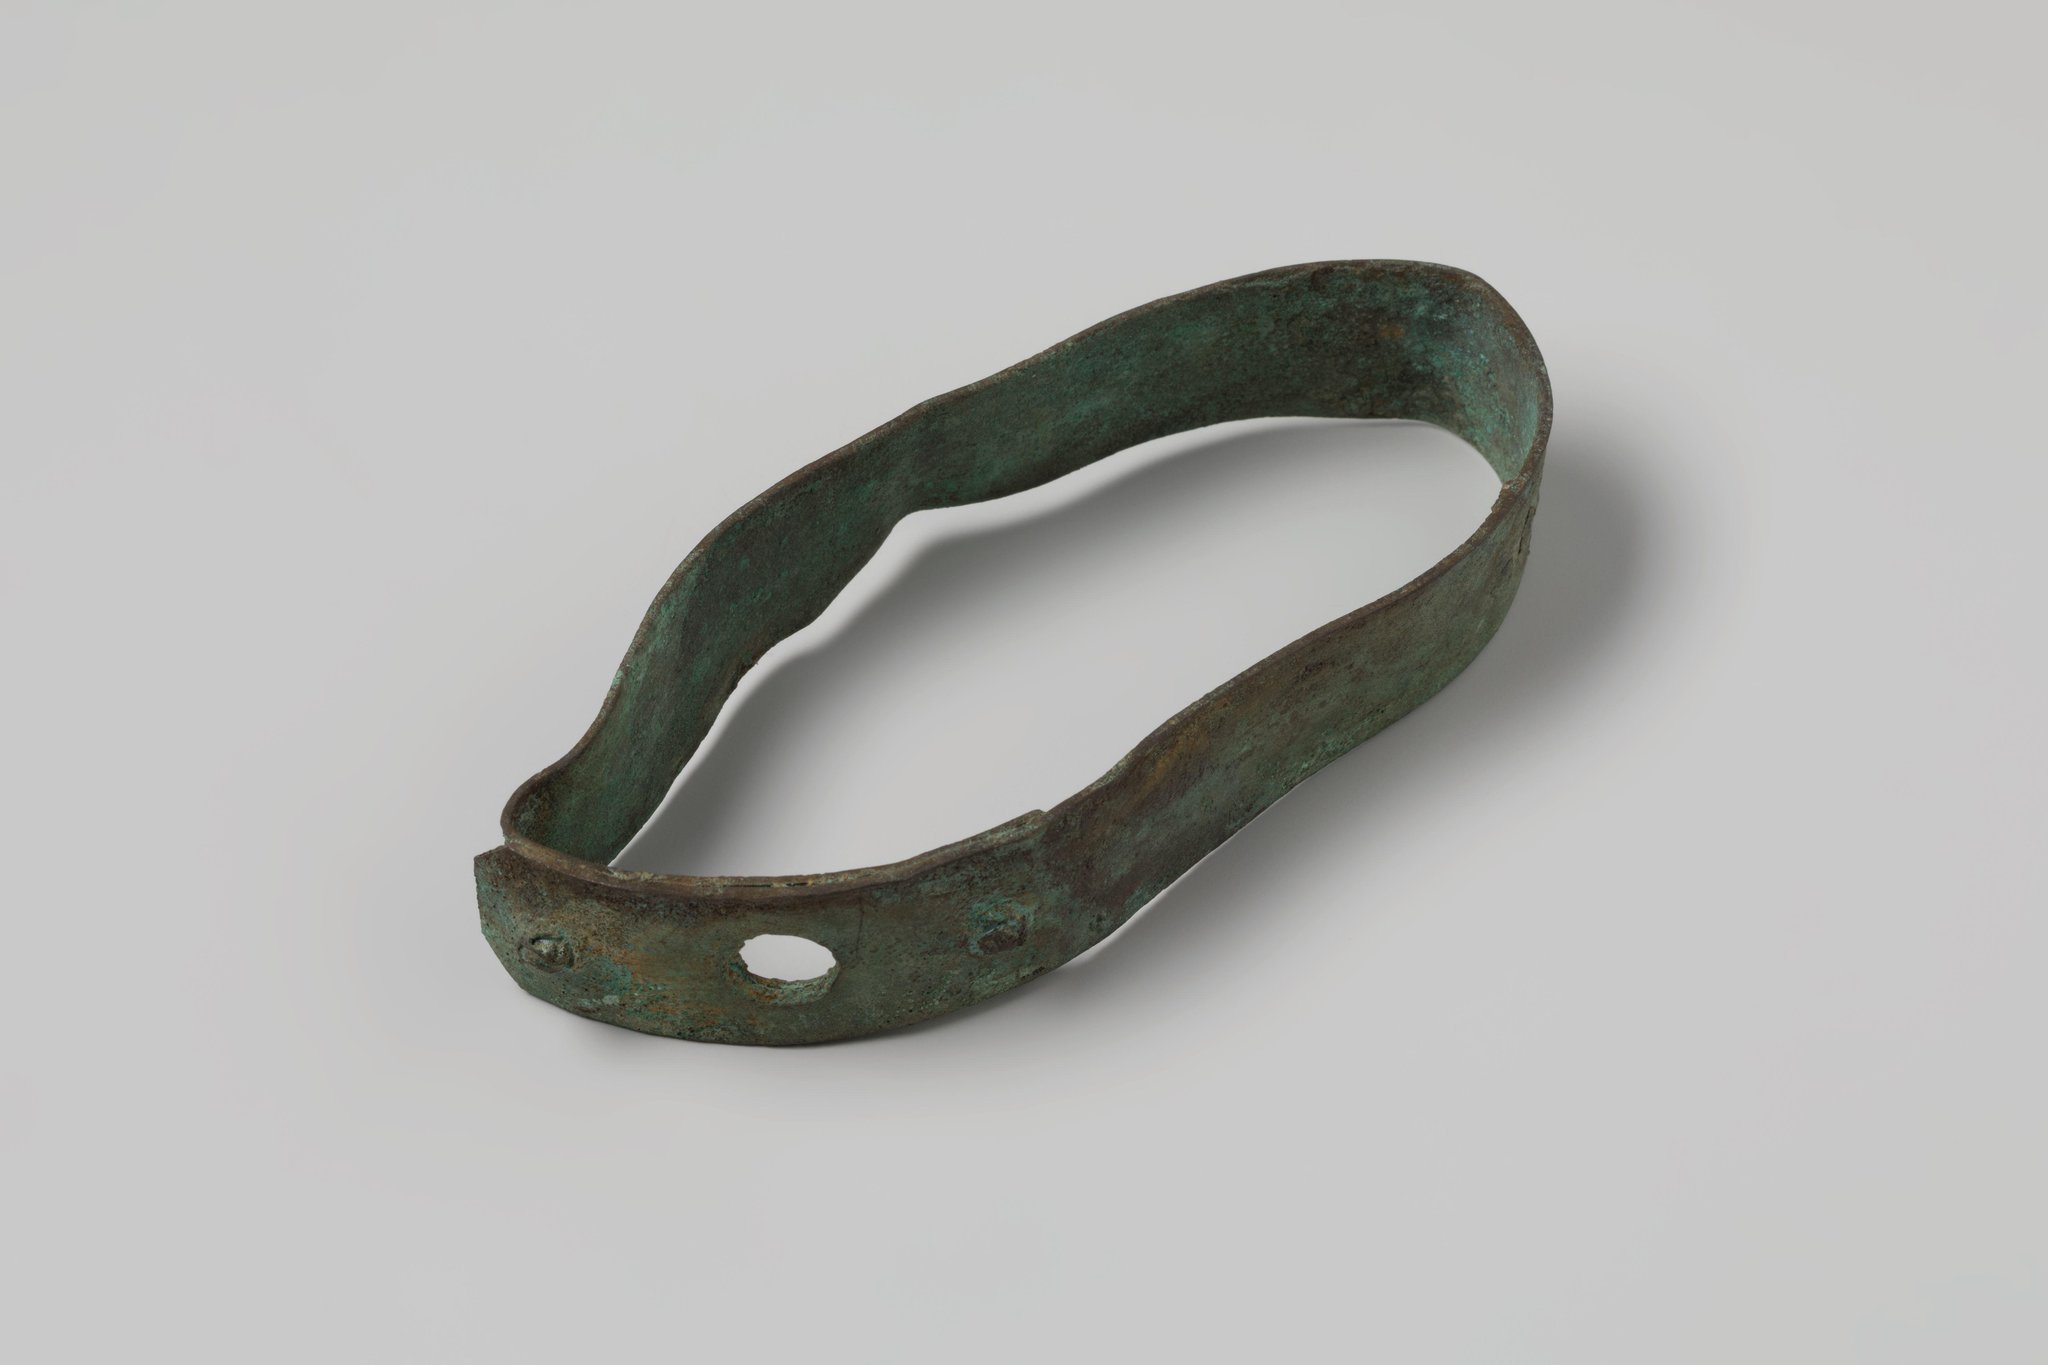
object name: ferrule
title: Beslagring uit het wrak van de Oost-Indiëvaarder Hollandia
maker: Anonymous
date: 1700-1743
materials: copper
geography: netherlands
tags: verenigde oostindische compagnie, hollandia (schip), annet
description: Fittings, bands and bracing, circular: riveted; squashed, strip with cut-corner ends, overlapping seam with 2 rivets, 1 circular hole.